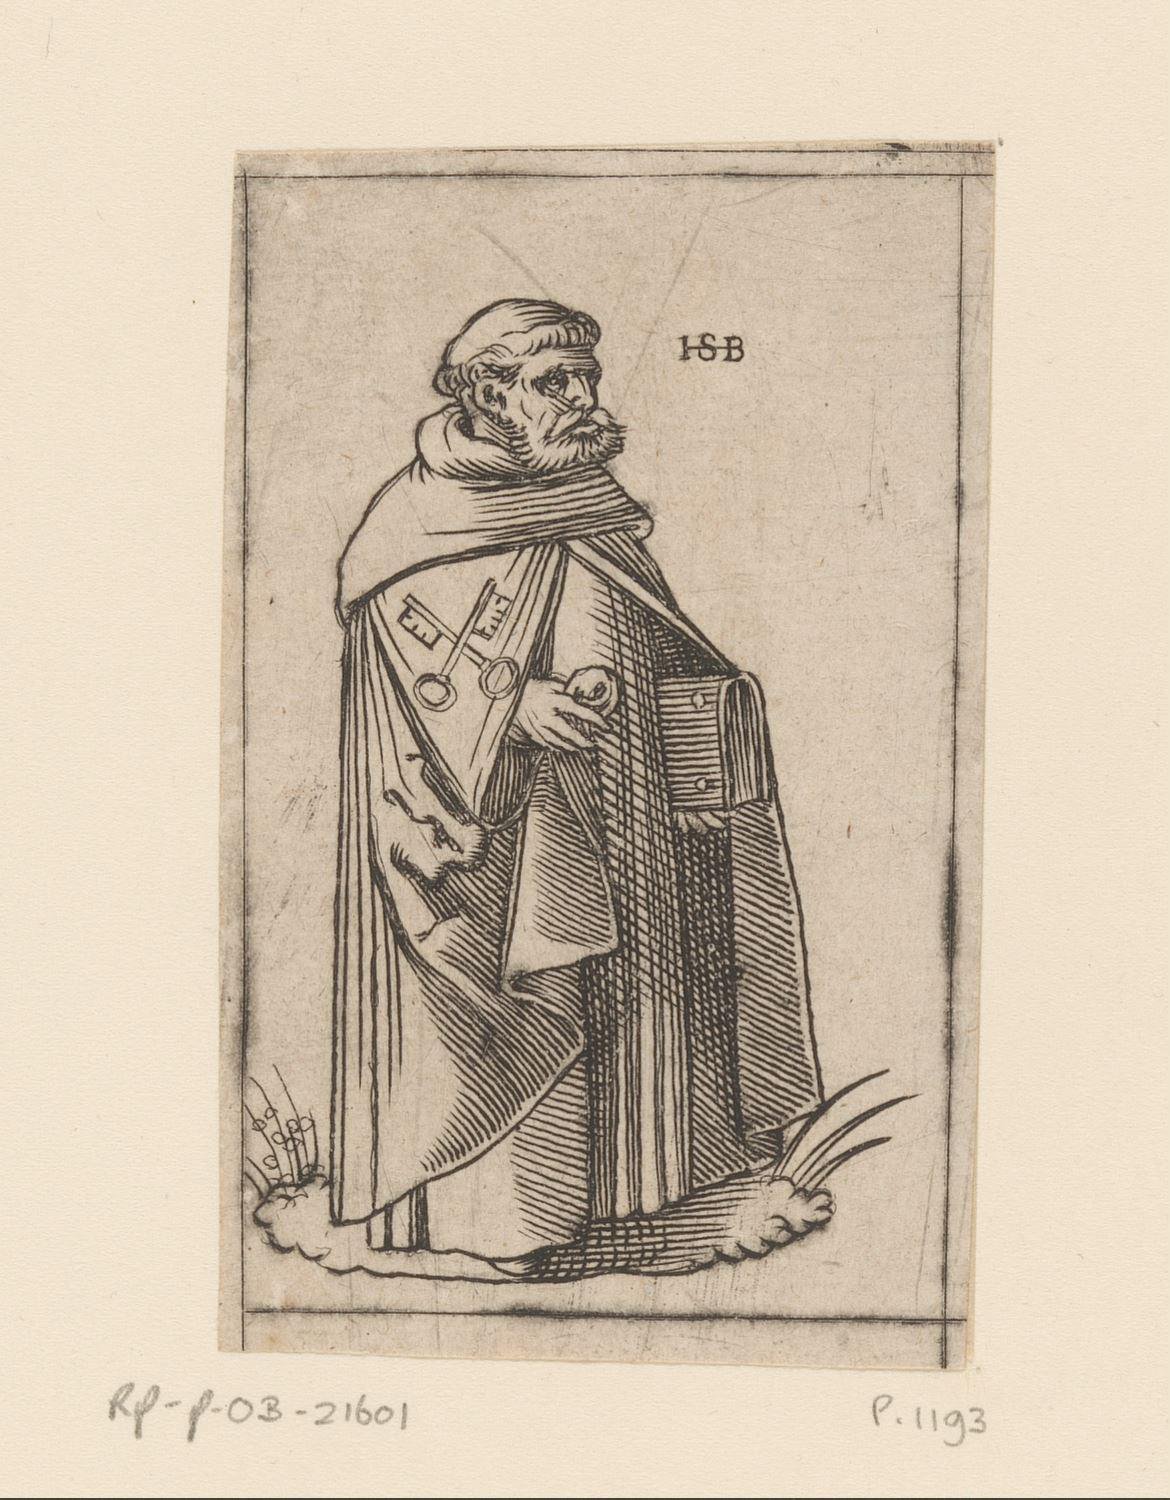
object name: print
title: Kostuums van geestelijken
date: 1526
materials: paper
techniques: engraving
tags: liturgical vestments, canonicals, monastic orders, monastic life ~ roman catholic church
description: Onderdeel van een serie van 28 gegraveerde kopieën in de andere richting naar Hans Sebald Behams "Das Papstthum mit seinen Gliedern", 1526.